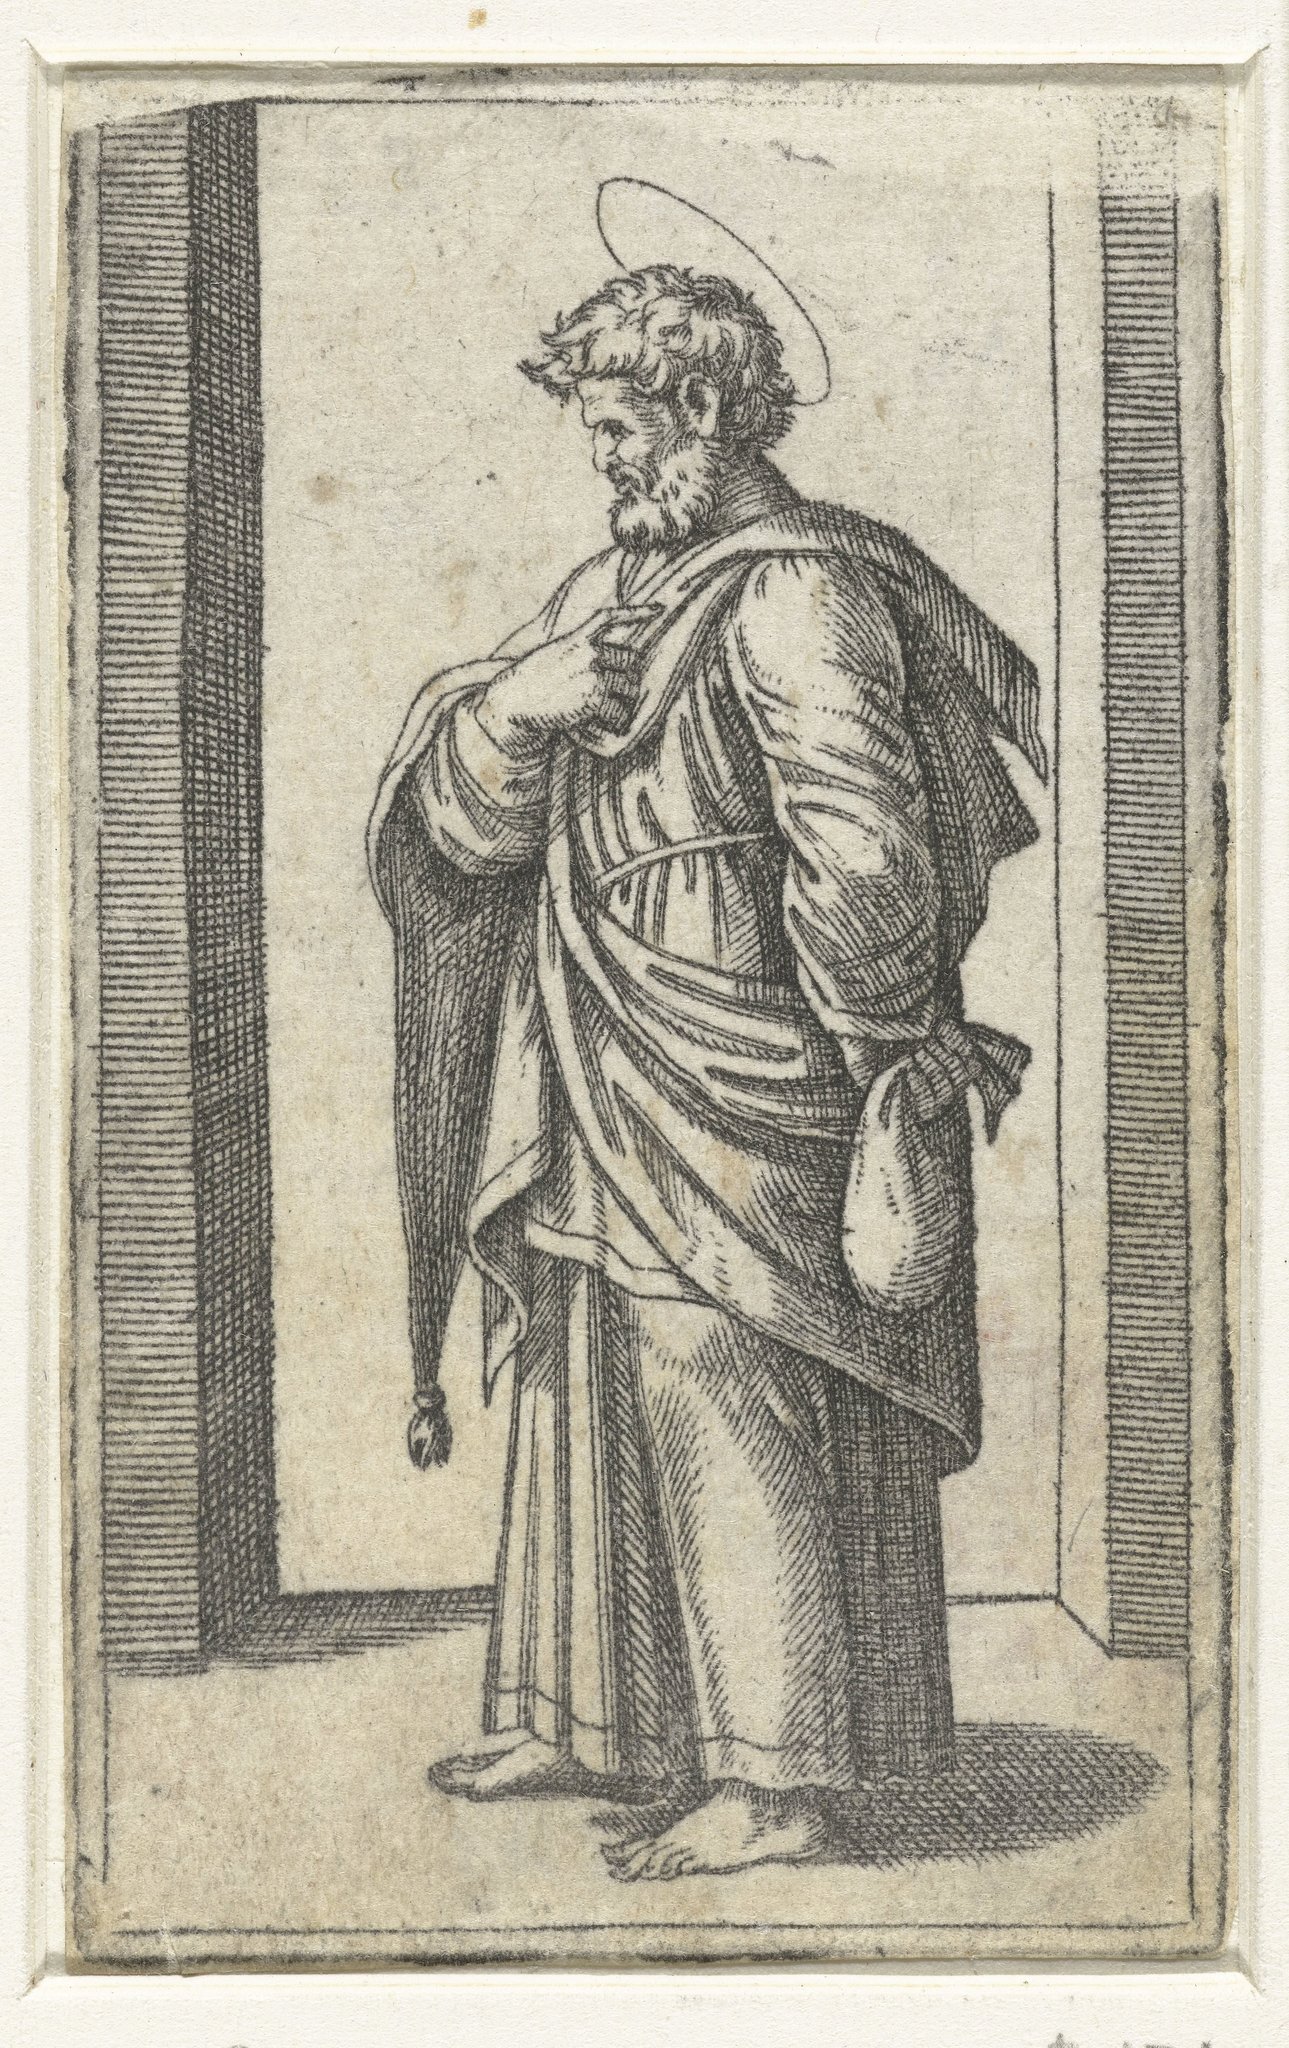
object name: print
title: Apostel Matteüs met beurs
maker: marcantonio raimondi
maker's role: print maker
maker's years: 1470-1534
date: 1517-1527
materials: paper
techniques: engraving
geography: italy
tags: the apostle and evangelist matthew (mattheus); possible attributes: angel, axe, book, halberd, pen and inkhorn, purse, scroll, square, sword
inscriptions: collector's mark: Lugt 12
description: Prent maakt deel uit van een serie van dertien kleine prenten van Christus en de apostelen naar ontwerp van Raphael.